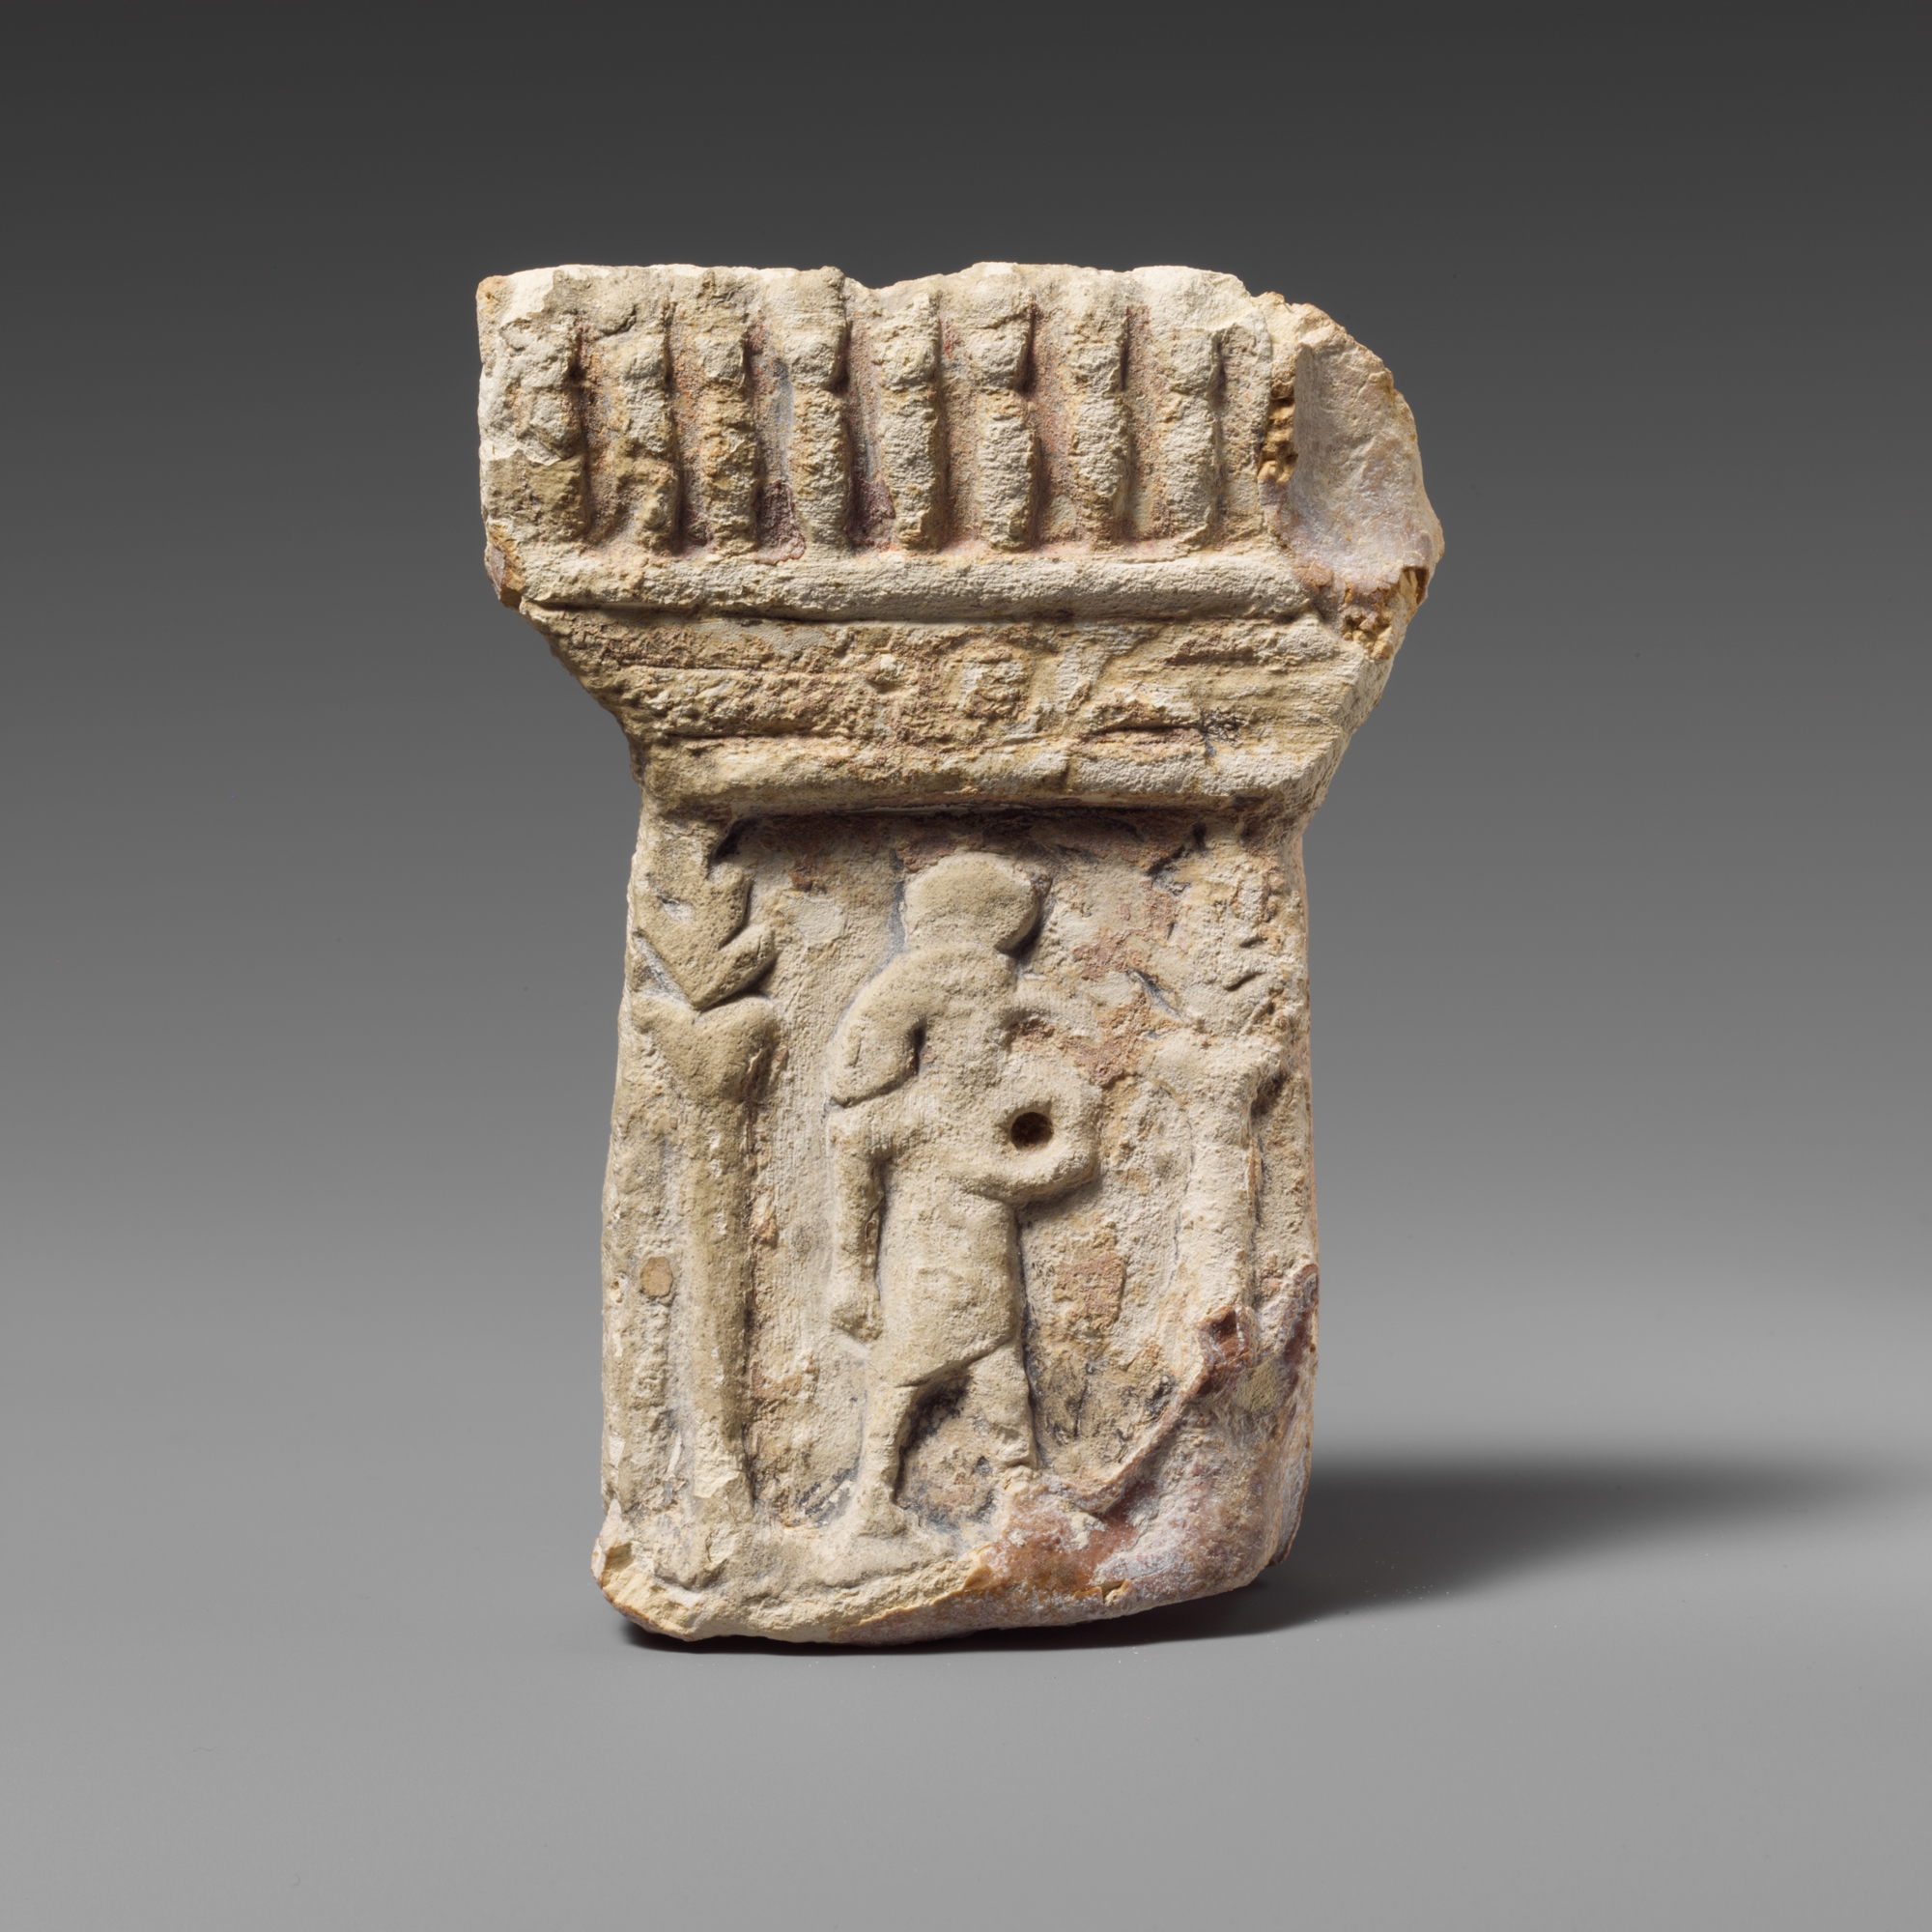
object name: altar shrine with thoth, miniature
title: Limestone naiskos with Egyptianizing decoration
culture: cypriot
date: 550-501 BCE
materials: chalk, limestone